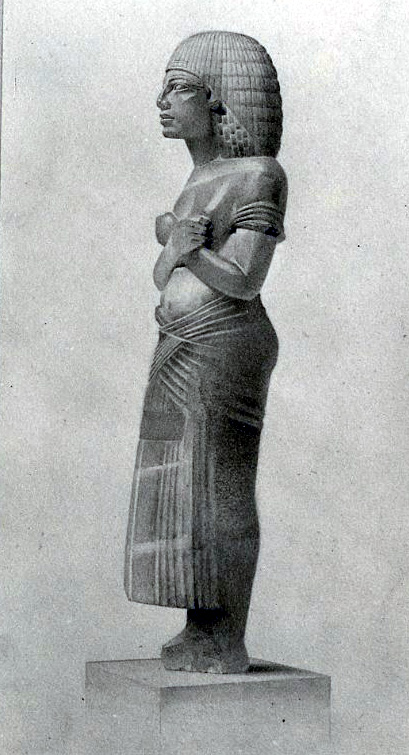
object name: facsimile, statuette, haremhab, kv 57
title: Facsimile Painting of an Alabaster Statuette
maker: lancelot crane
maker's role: artist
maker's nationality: british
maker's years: 1880-1918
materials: paper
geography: egypt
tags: men